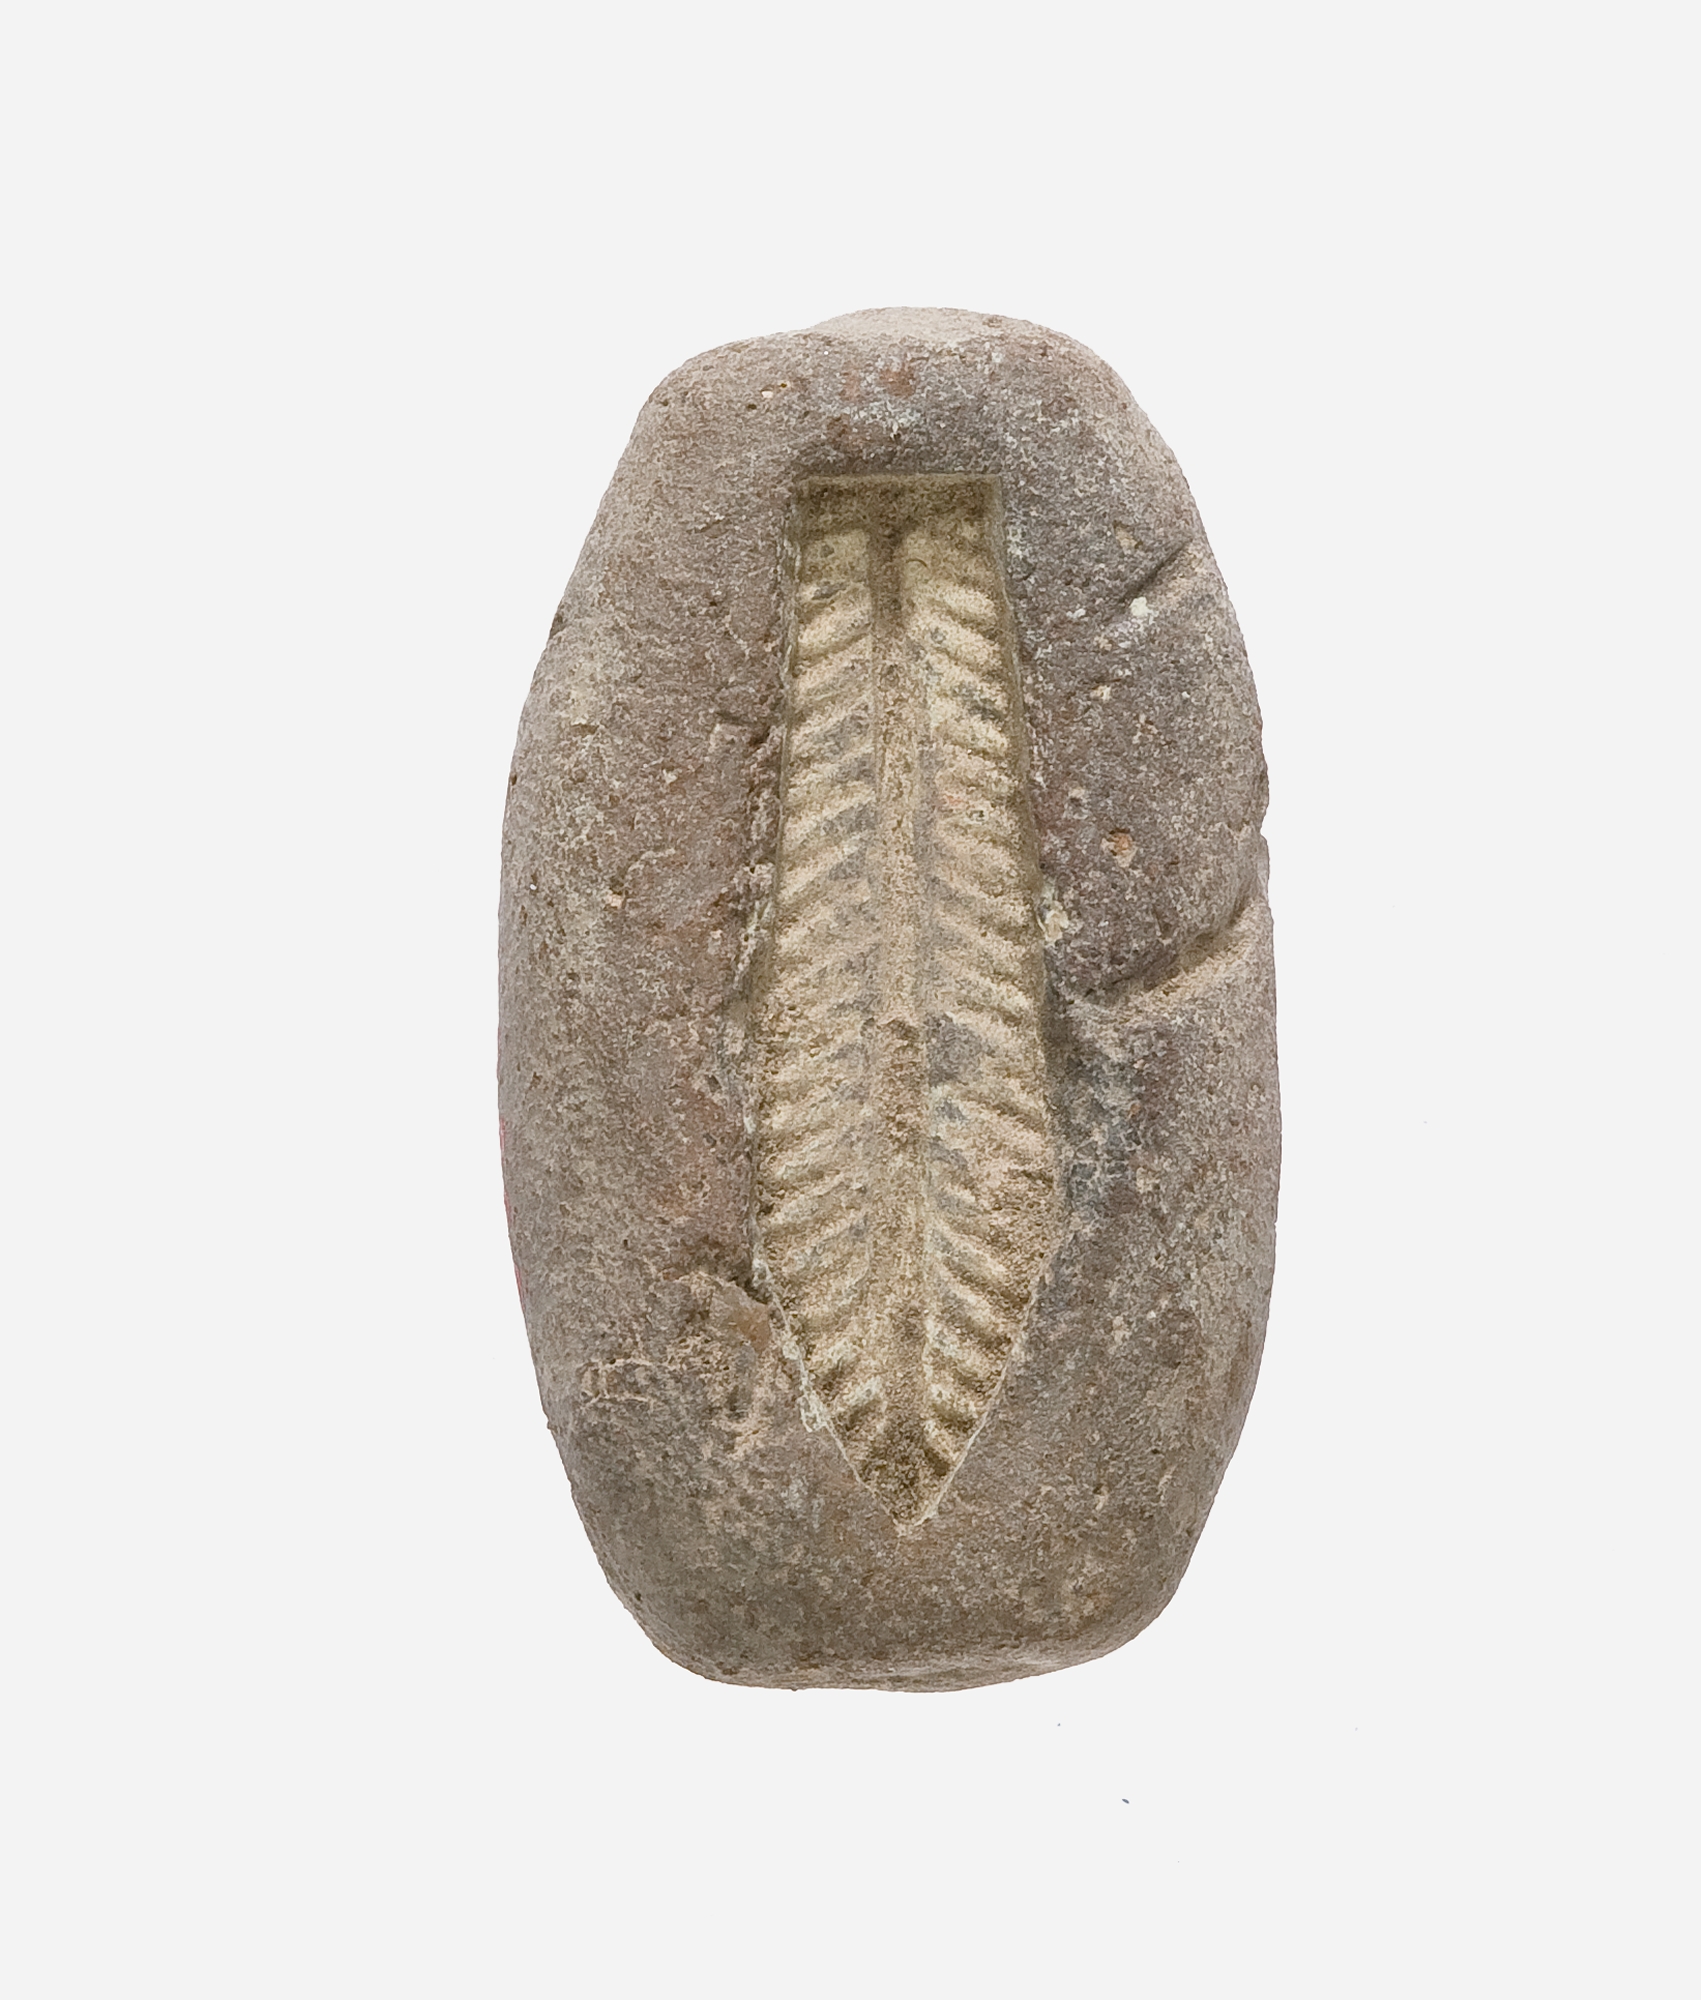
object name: mold, bead, leaf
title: Mold for Leaf Bead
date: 1390-1352 BCE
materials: pottery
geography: egypt